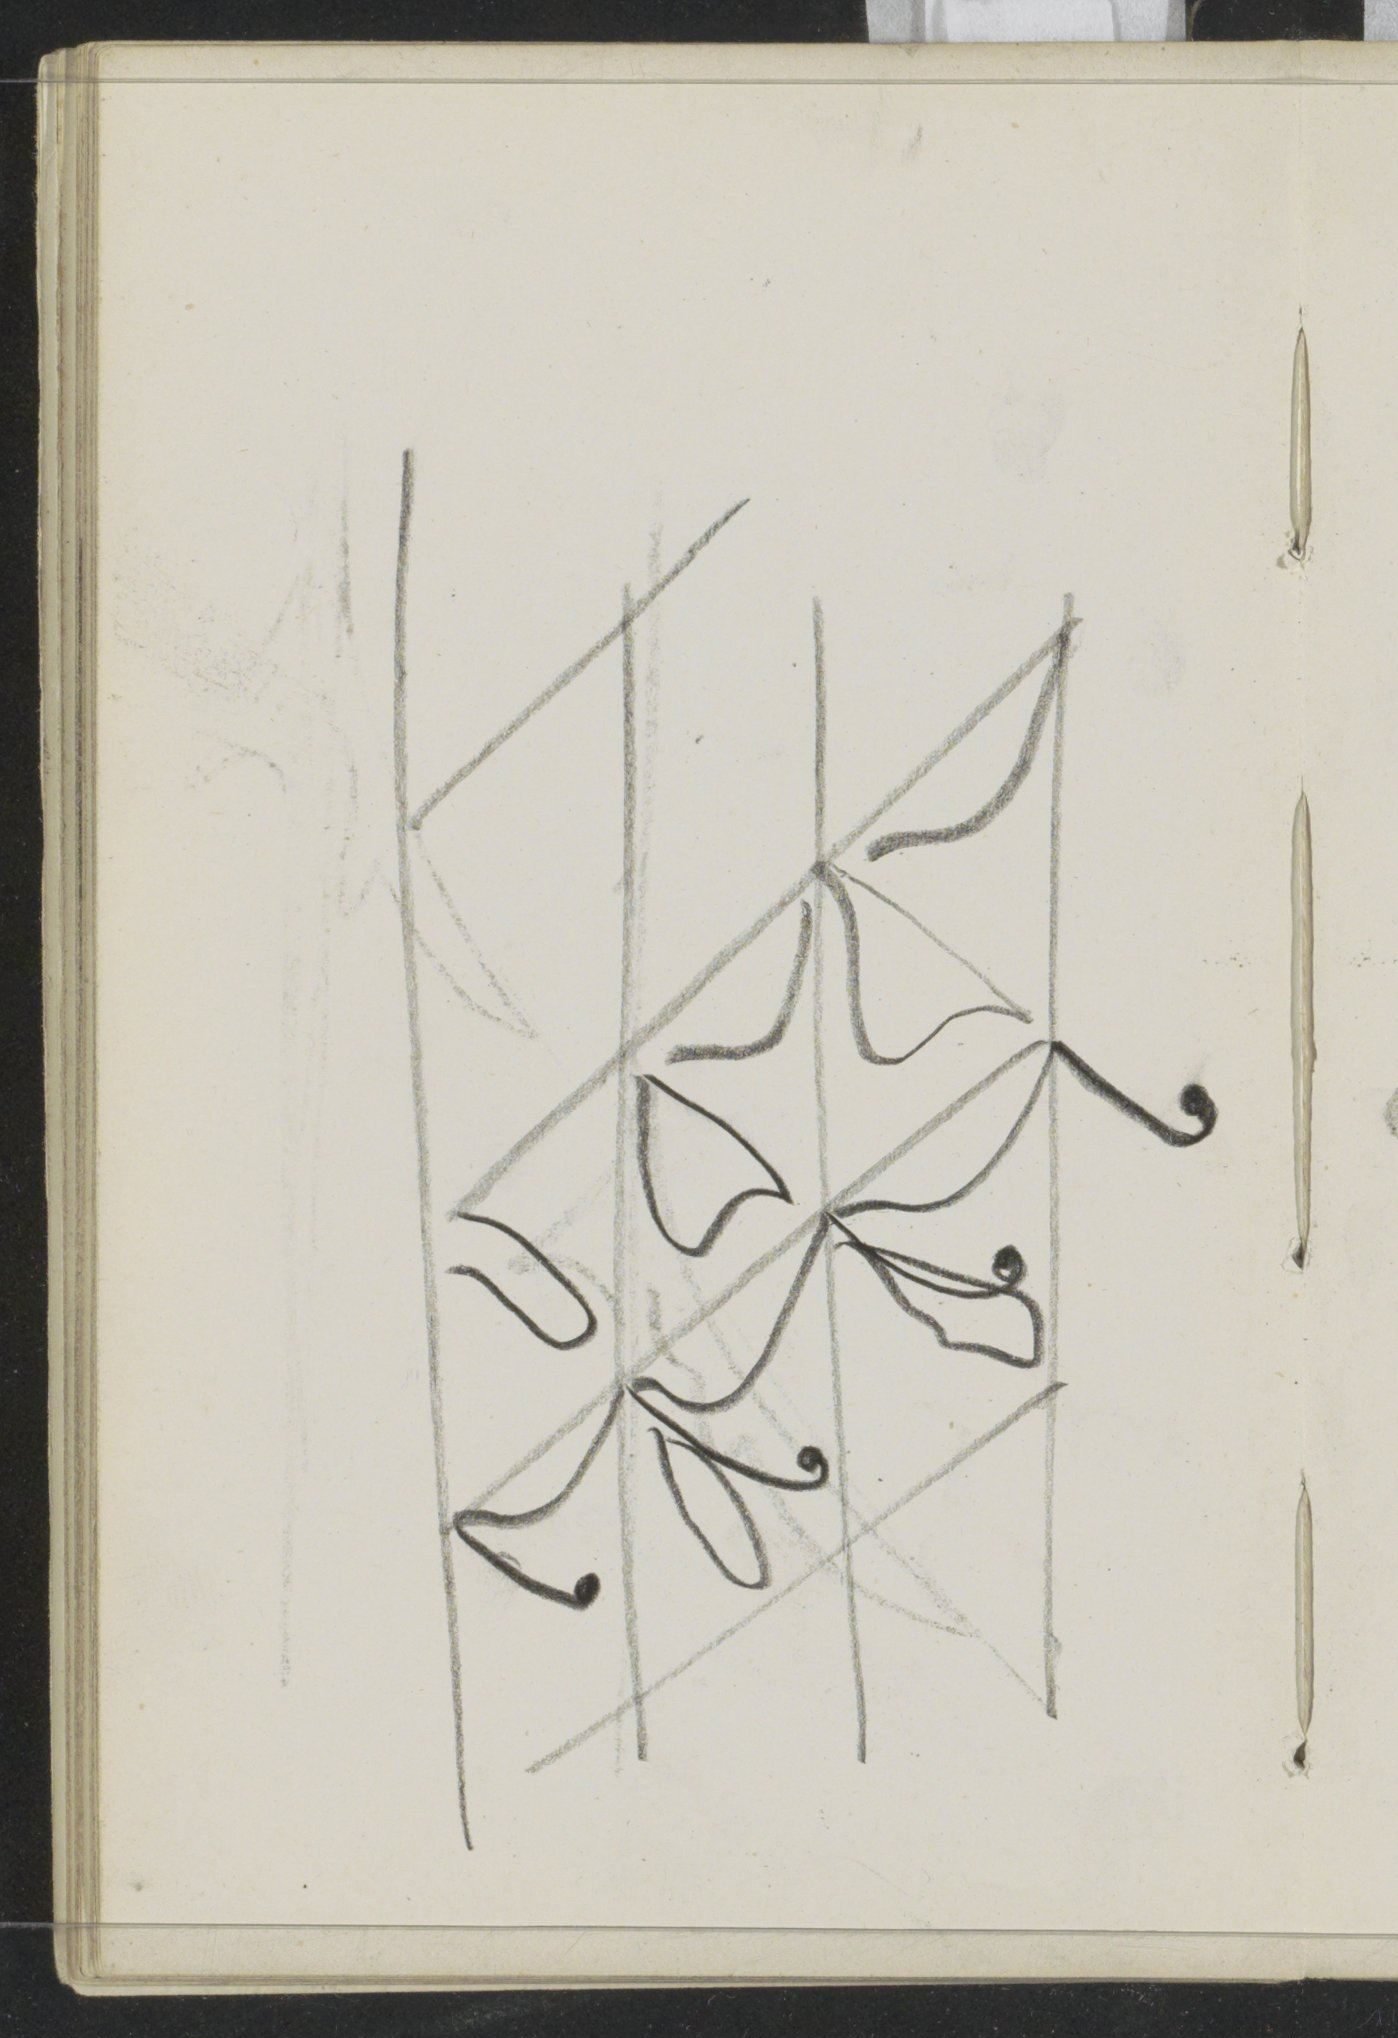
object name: sketchbook leaf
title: Floraal motief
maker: carel adolph lion cachet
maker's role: draughtsman, print maker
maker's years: 1864-1945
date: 1874-1945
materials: chalk, paper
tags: flowers ~ ornament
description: Blad 32 verso uit een schetsboek met 41 bladen.